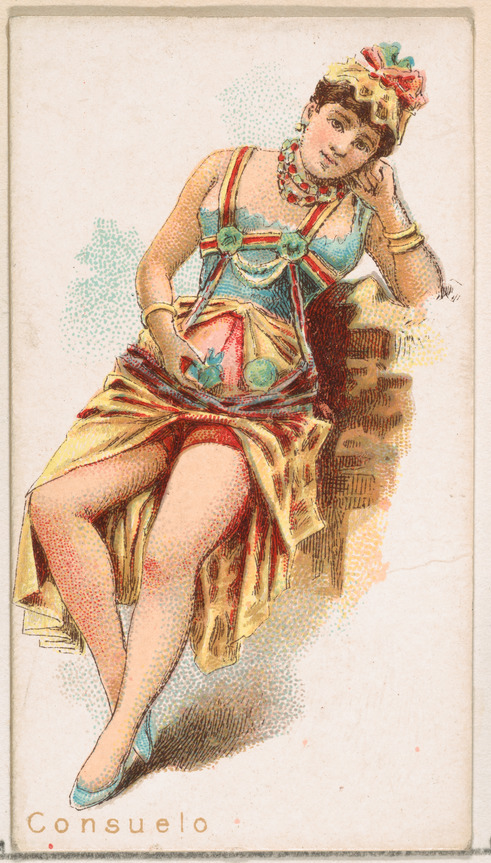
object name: print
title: Consuelo, from the Ballet Queens series (N182) issued by Wm. S. Kimball & Co.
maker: william s. kimball & company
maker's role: publisher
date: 1889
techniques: color lithograph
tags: women